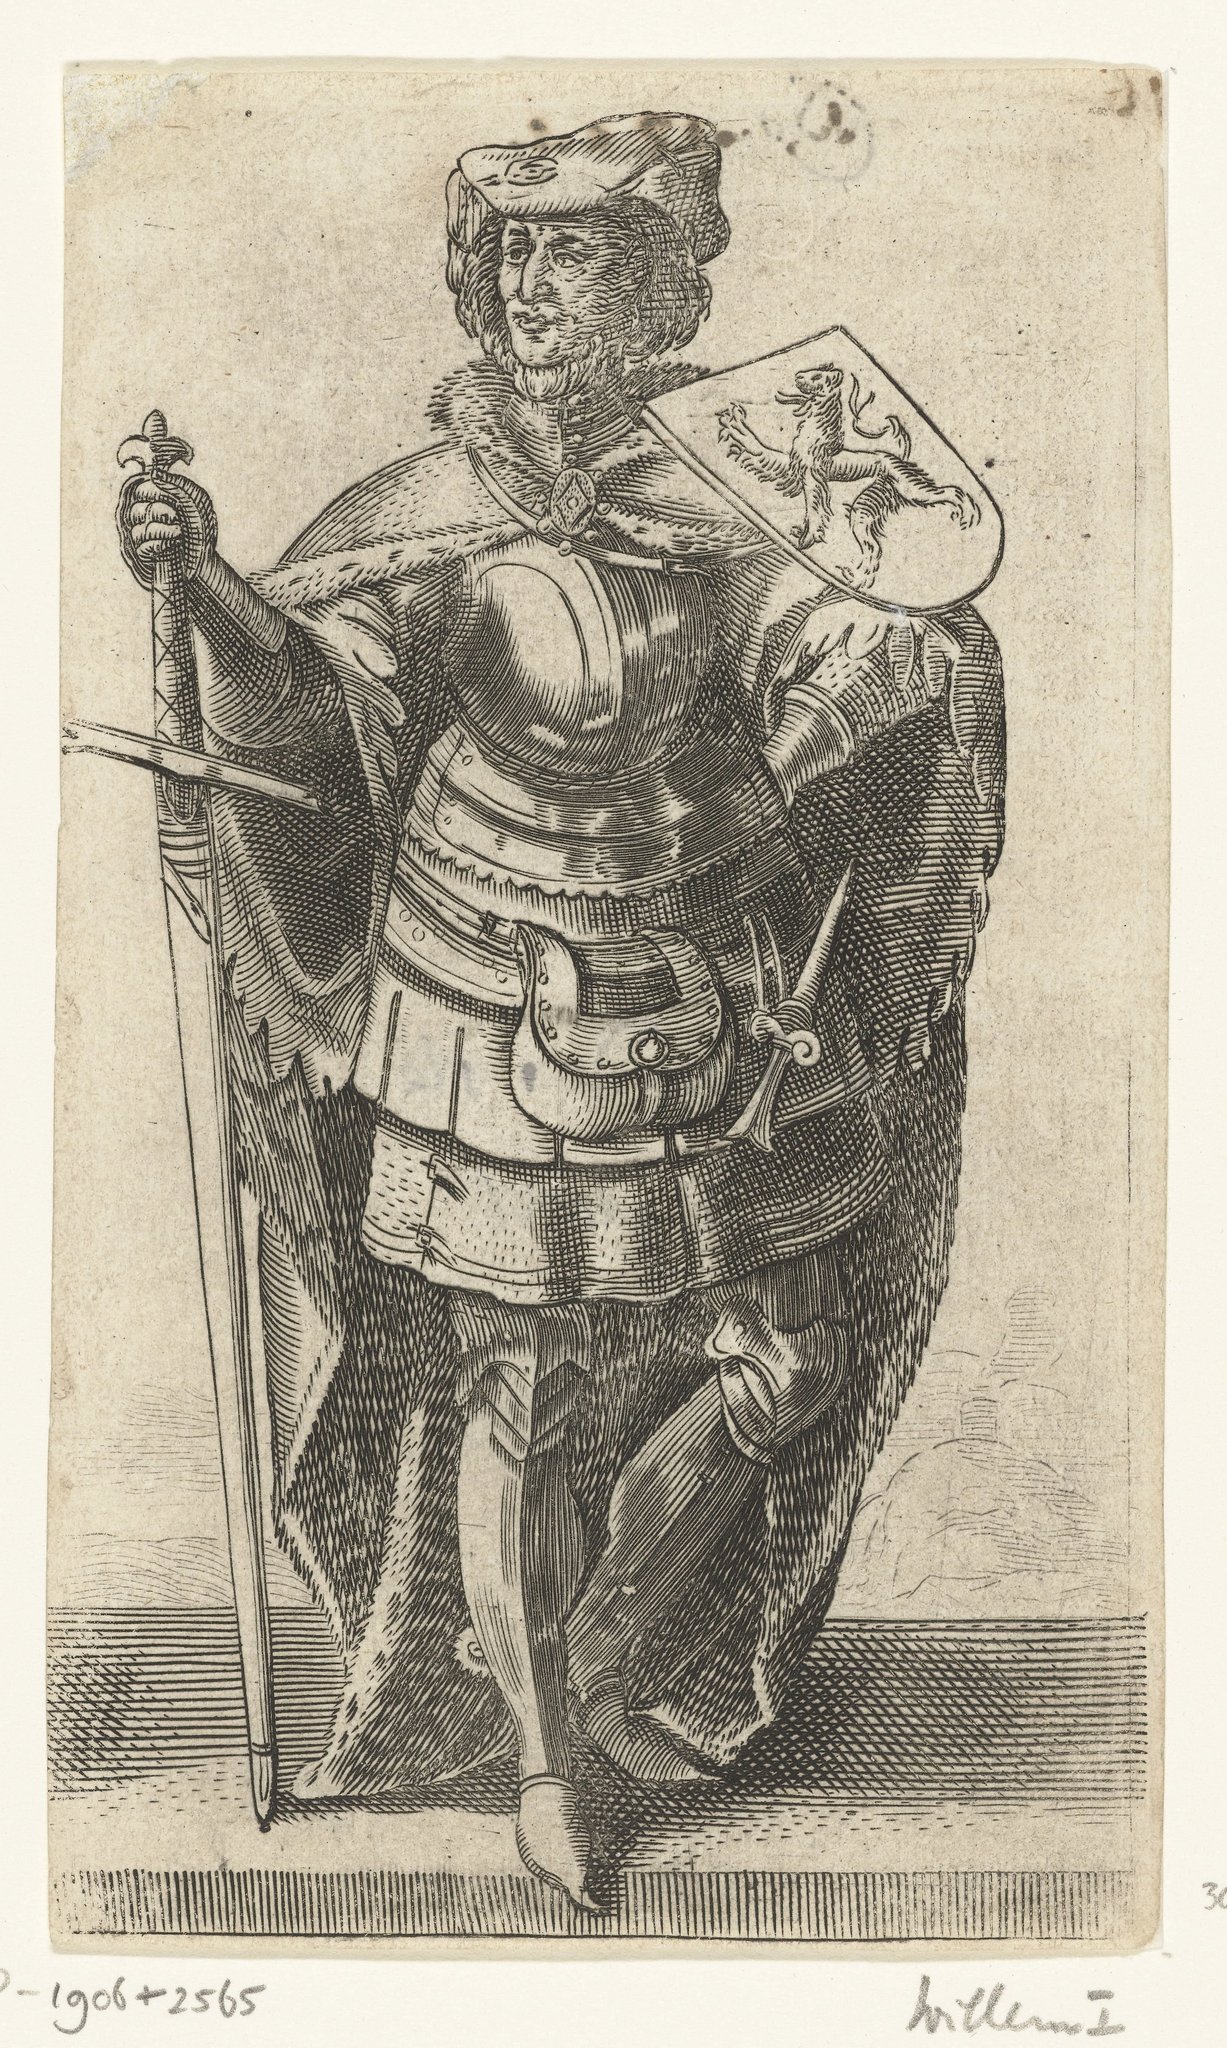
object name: print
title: Graven en gravinnen van Holland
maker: adriaen matham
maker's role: draughtsman, print maker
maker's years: 1599-1660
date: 1620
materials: paper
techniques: engraving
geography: haarlem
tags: nobility and patriciate; chivalry, knighthood, county of holland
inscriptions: number: ‘1204’, name: ‘willem de 1ste/ 12de graaf’, collector's mark: Lugt 2228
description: Portret van Willem I, graaf van Holland, staande in een harnas met op zijn schouder het wapen van Holland en in zijn hand een zwaard. Prent uit een serie van 36 prenten met portretten ten voeten uit van graven en gravinnen van Holland.